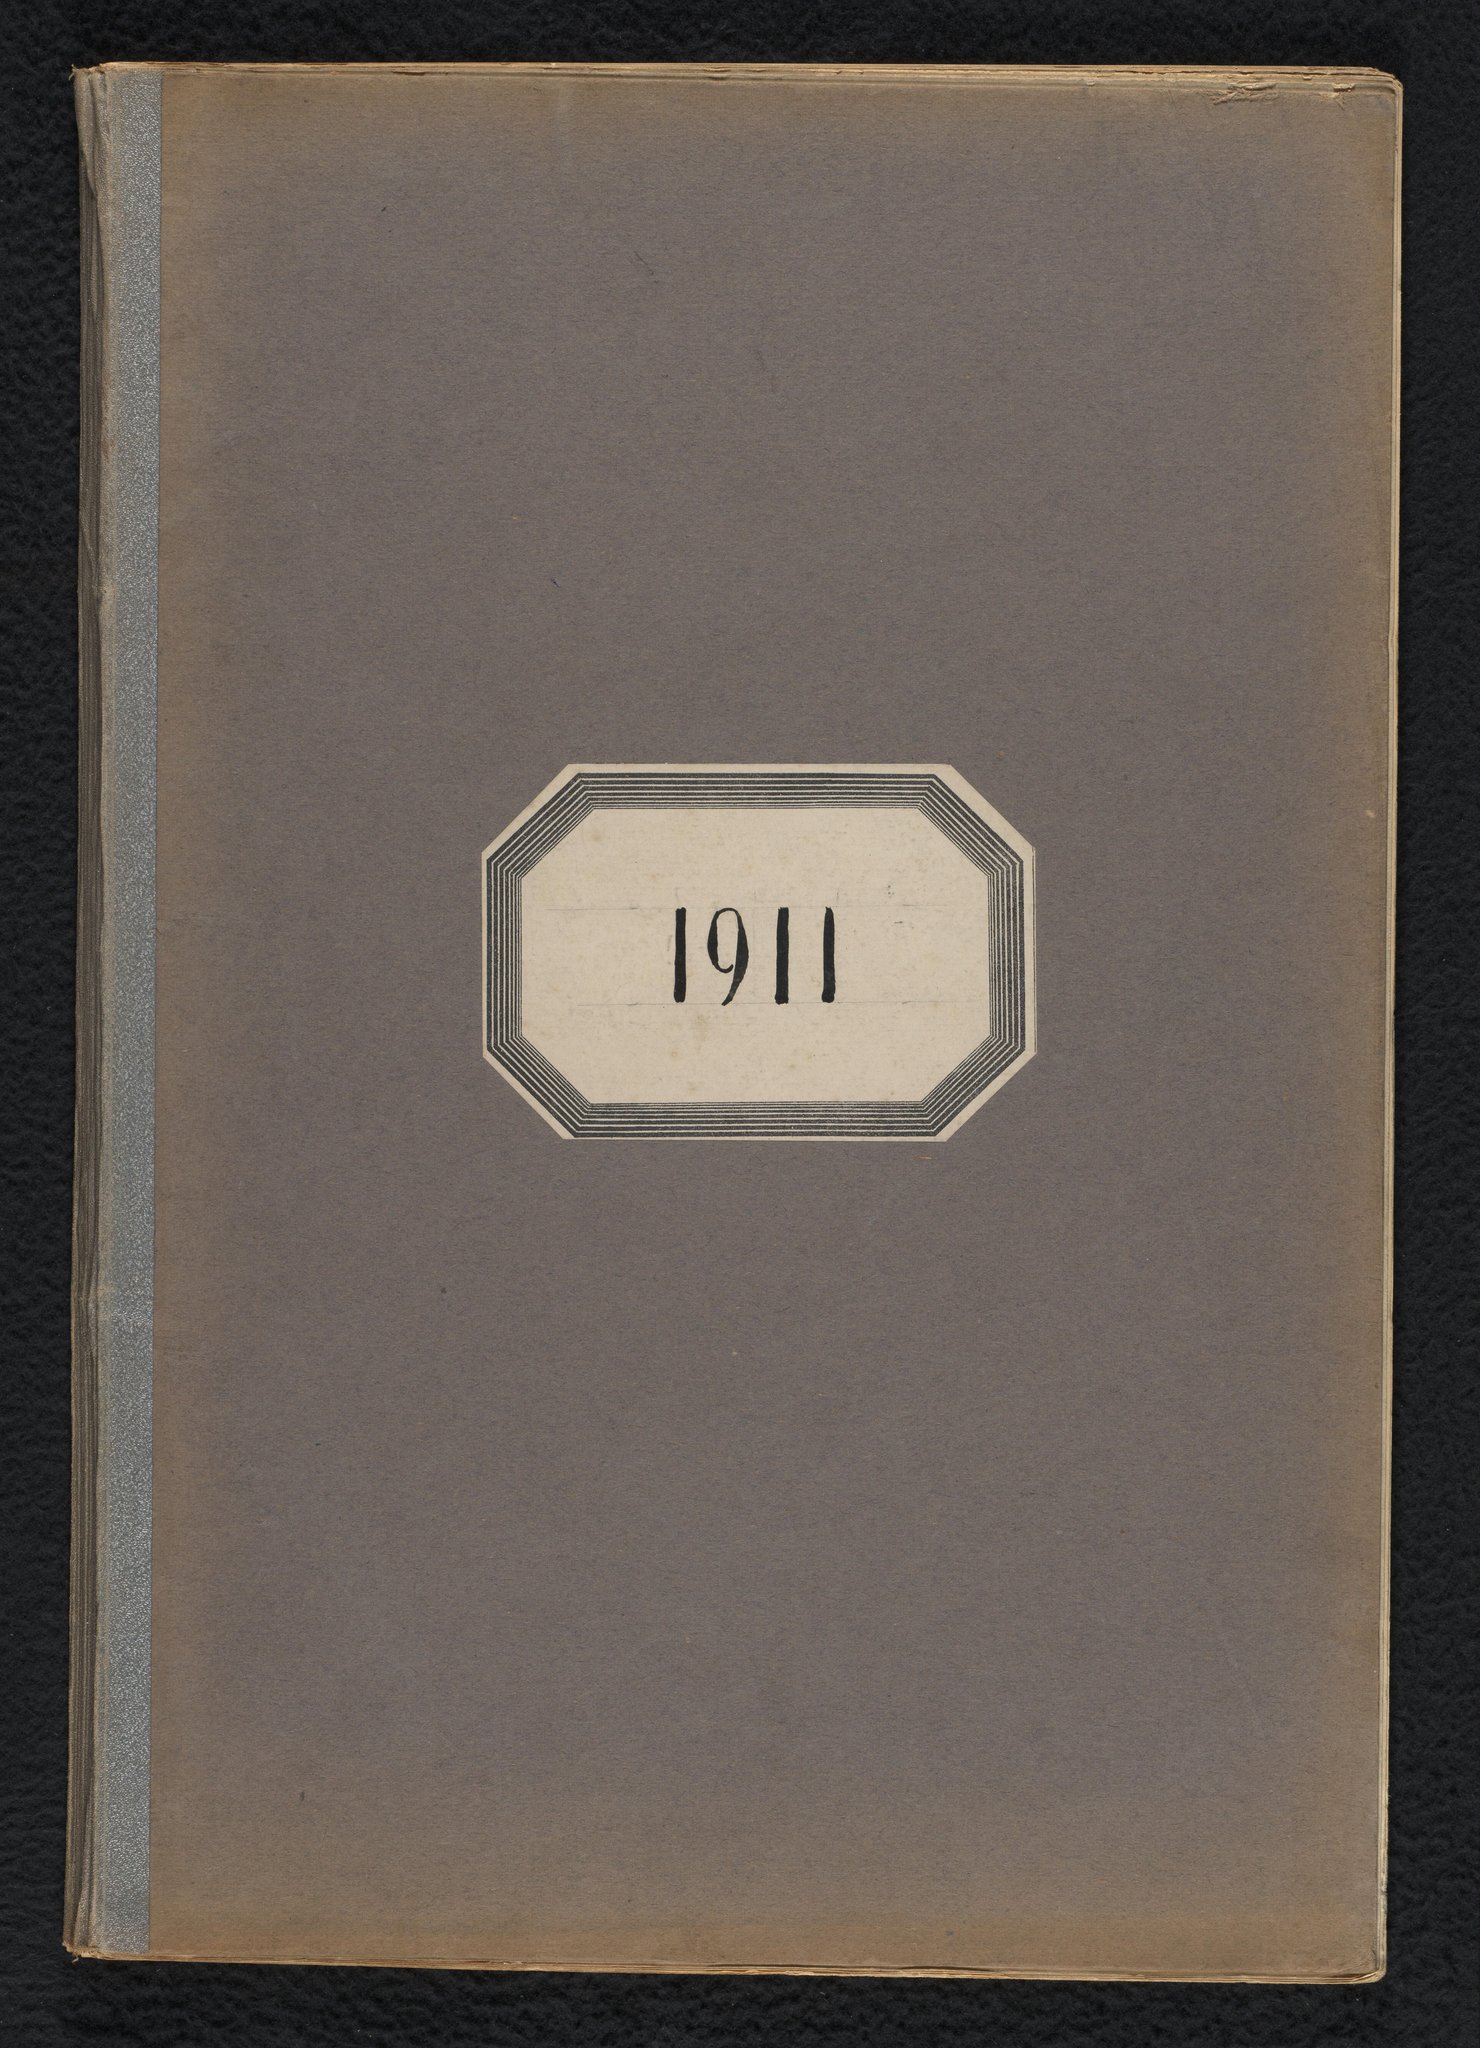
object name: cartoon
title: Spotprenten uit 'De Amsterdammer' van het jaar 1911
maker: johan braakensiek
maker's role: draughtsman, print maker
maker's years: 1858-1940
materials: paper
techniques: lithograph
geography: amsterdam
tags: political caricatures and satires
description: Bundel van 55 spotprenten van Braakensiek gepubliceerd als bijvoegsel bij 'De Amsterdammer' in het jaar 1911. Bundel geplakt in slappe omslag van grijsgroen karton met handgeschreven etiket '1911'.